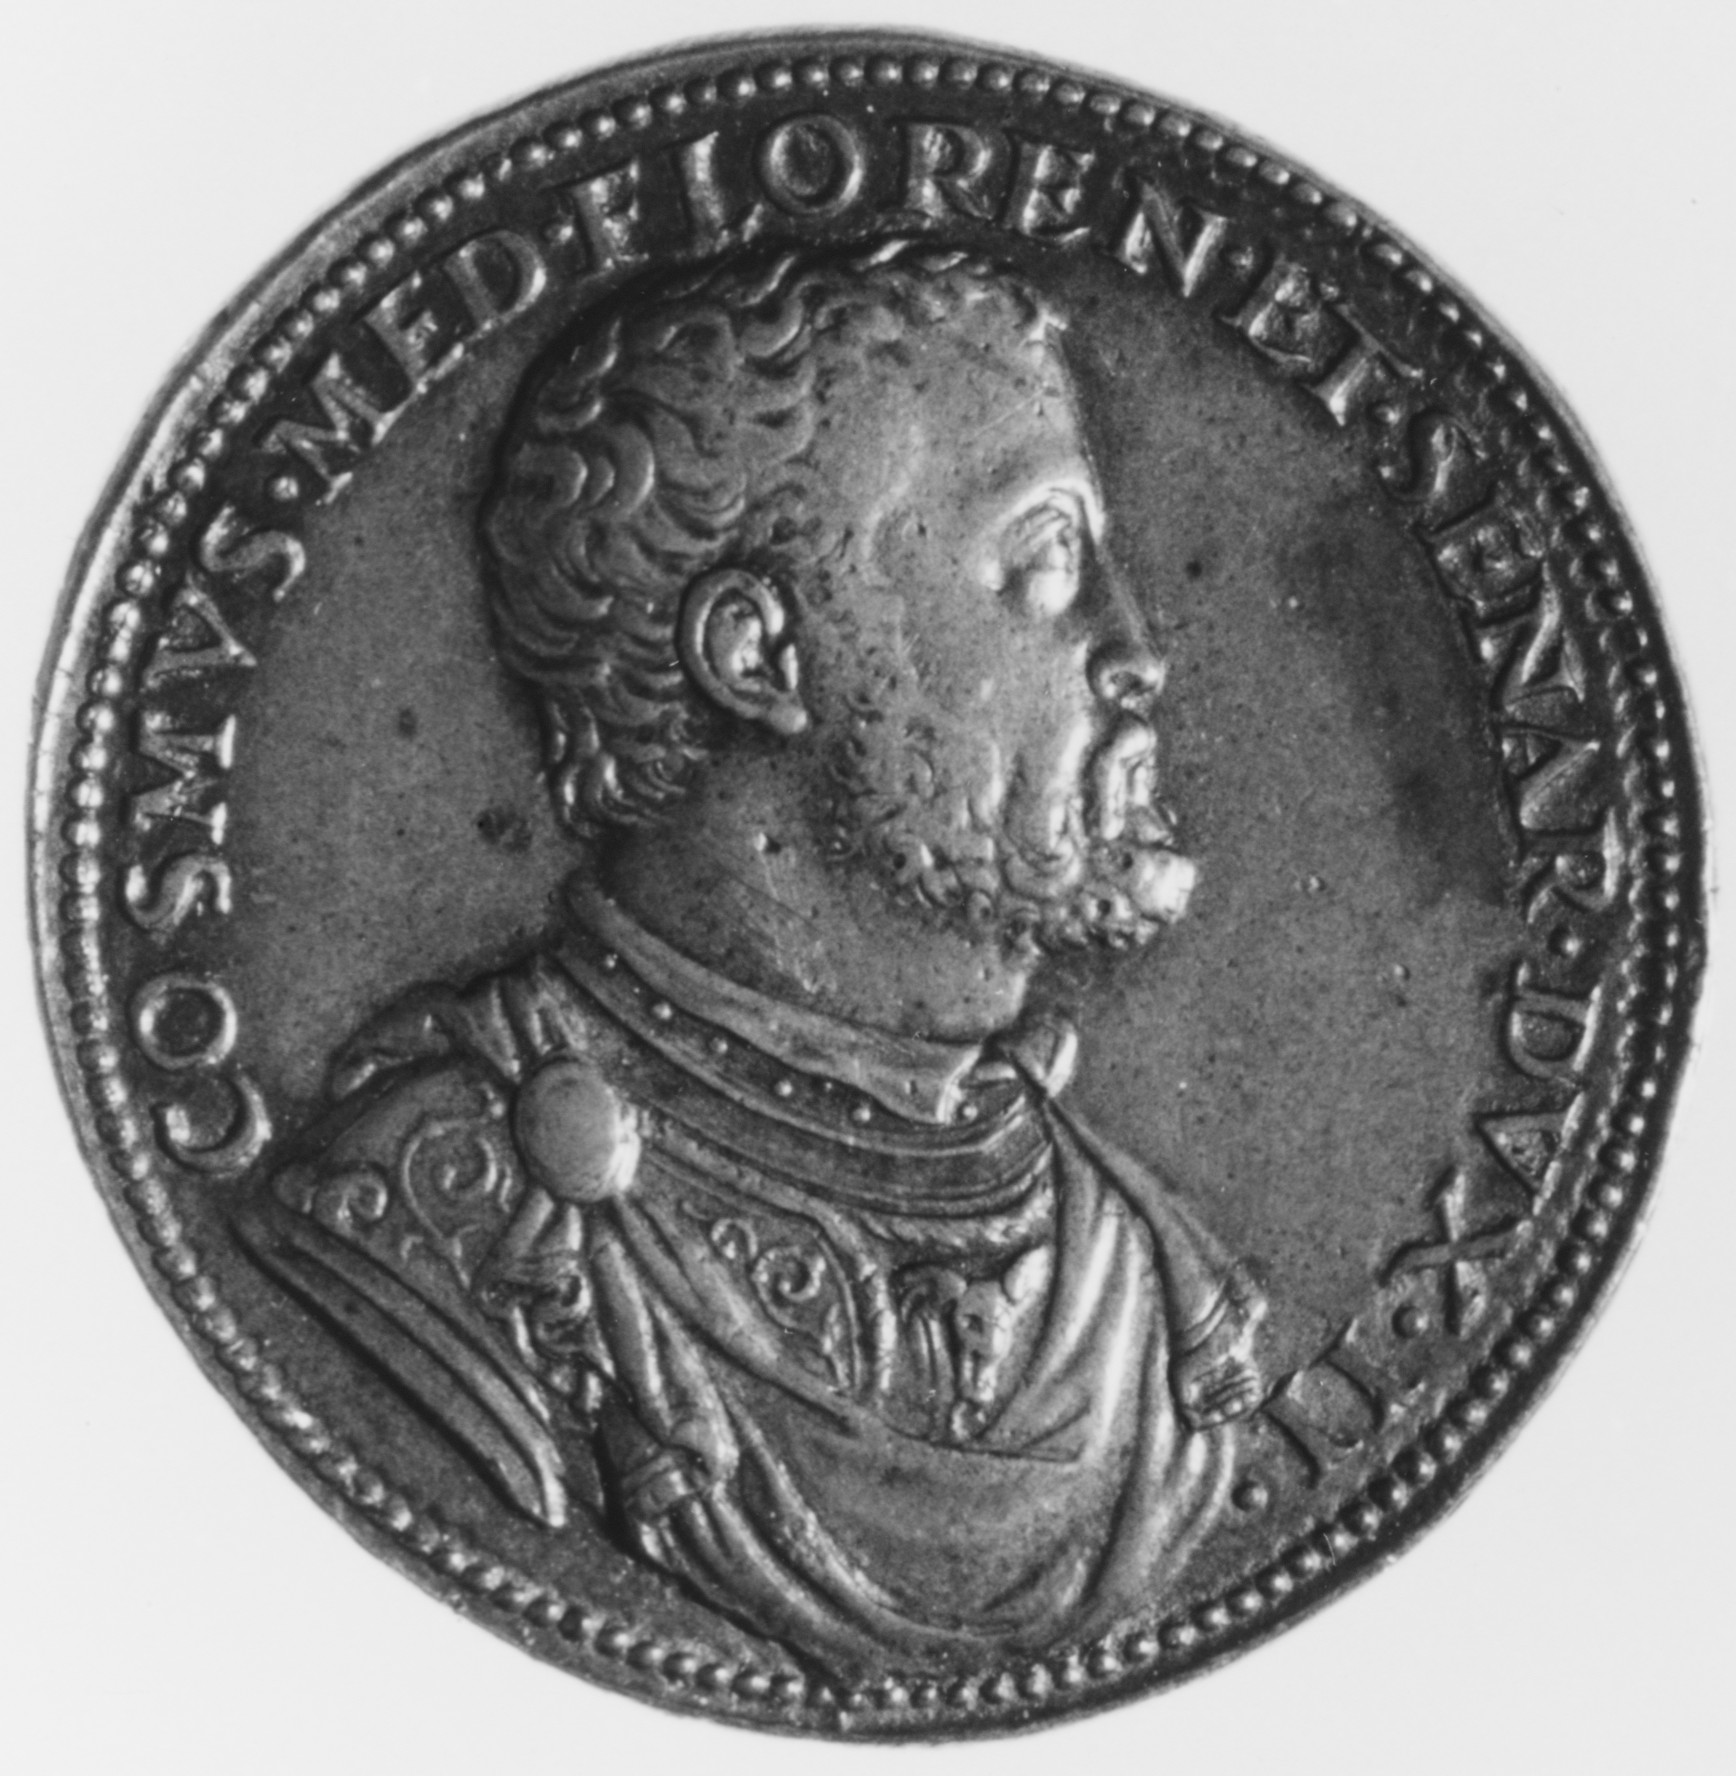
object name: medal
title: Cosimo I de' Medici, Duke of Florence and Siena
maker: pietro paolo galeotti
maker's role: artist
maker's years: 1500-1600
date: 1557-1569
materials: bronze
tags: men,profiles